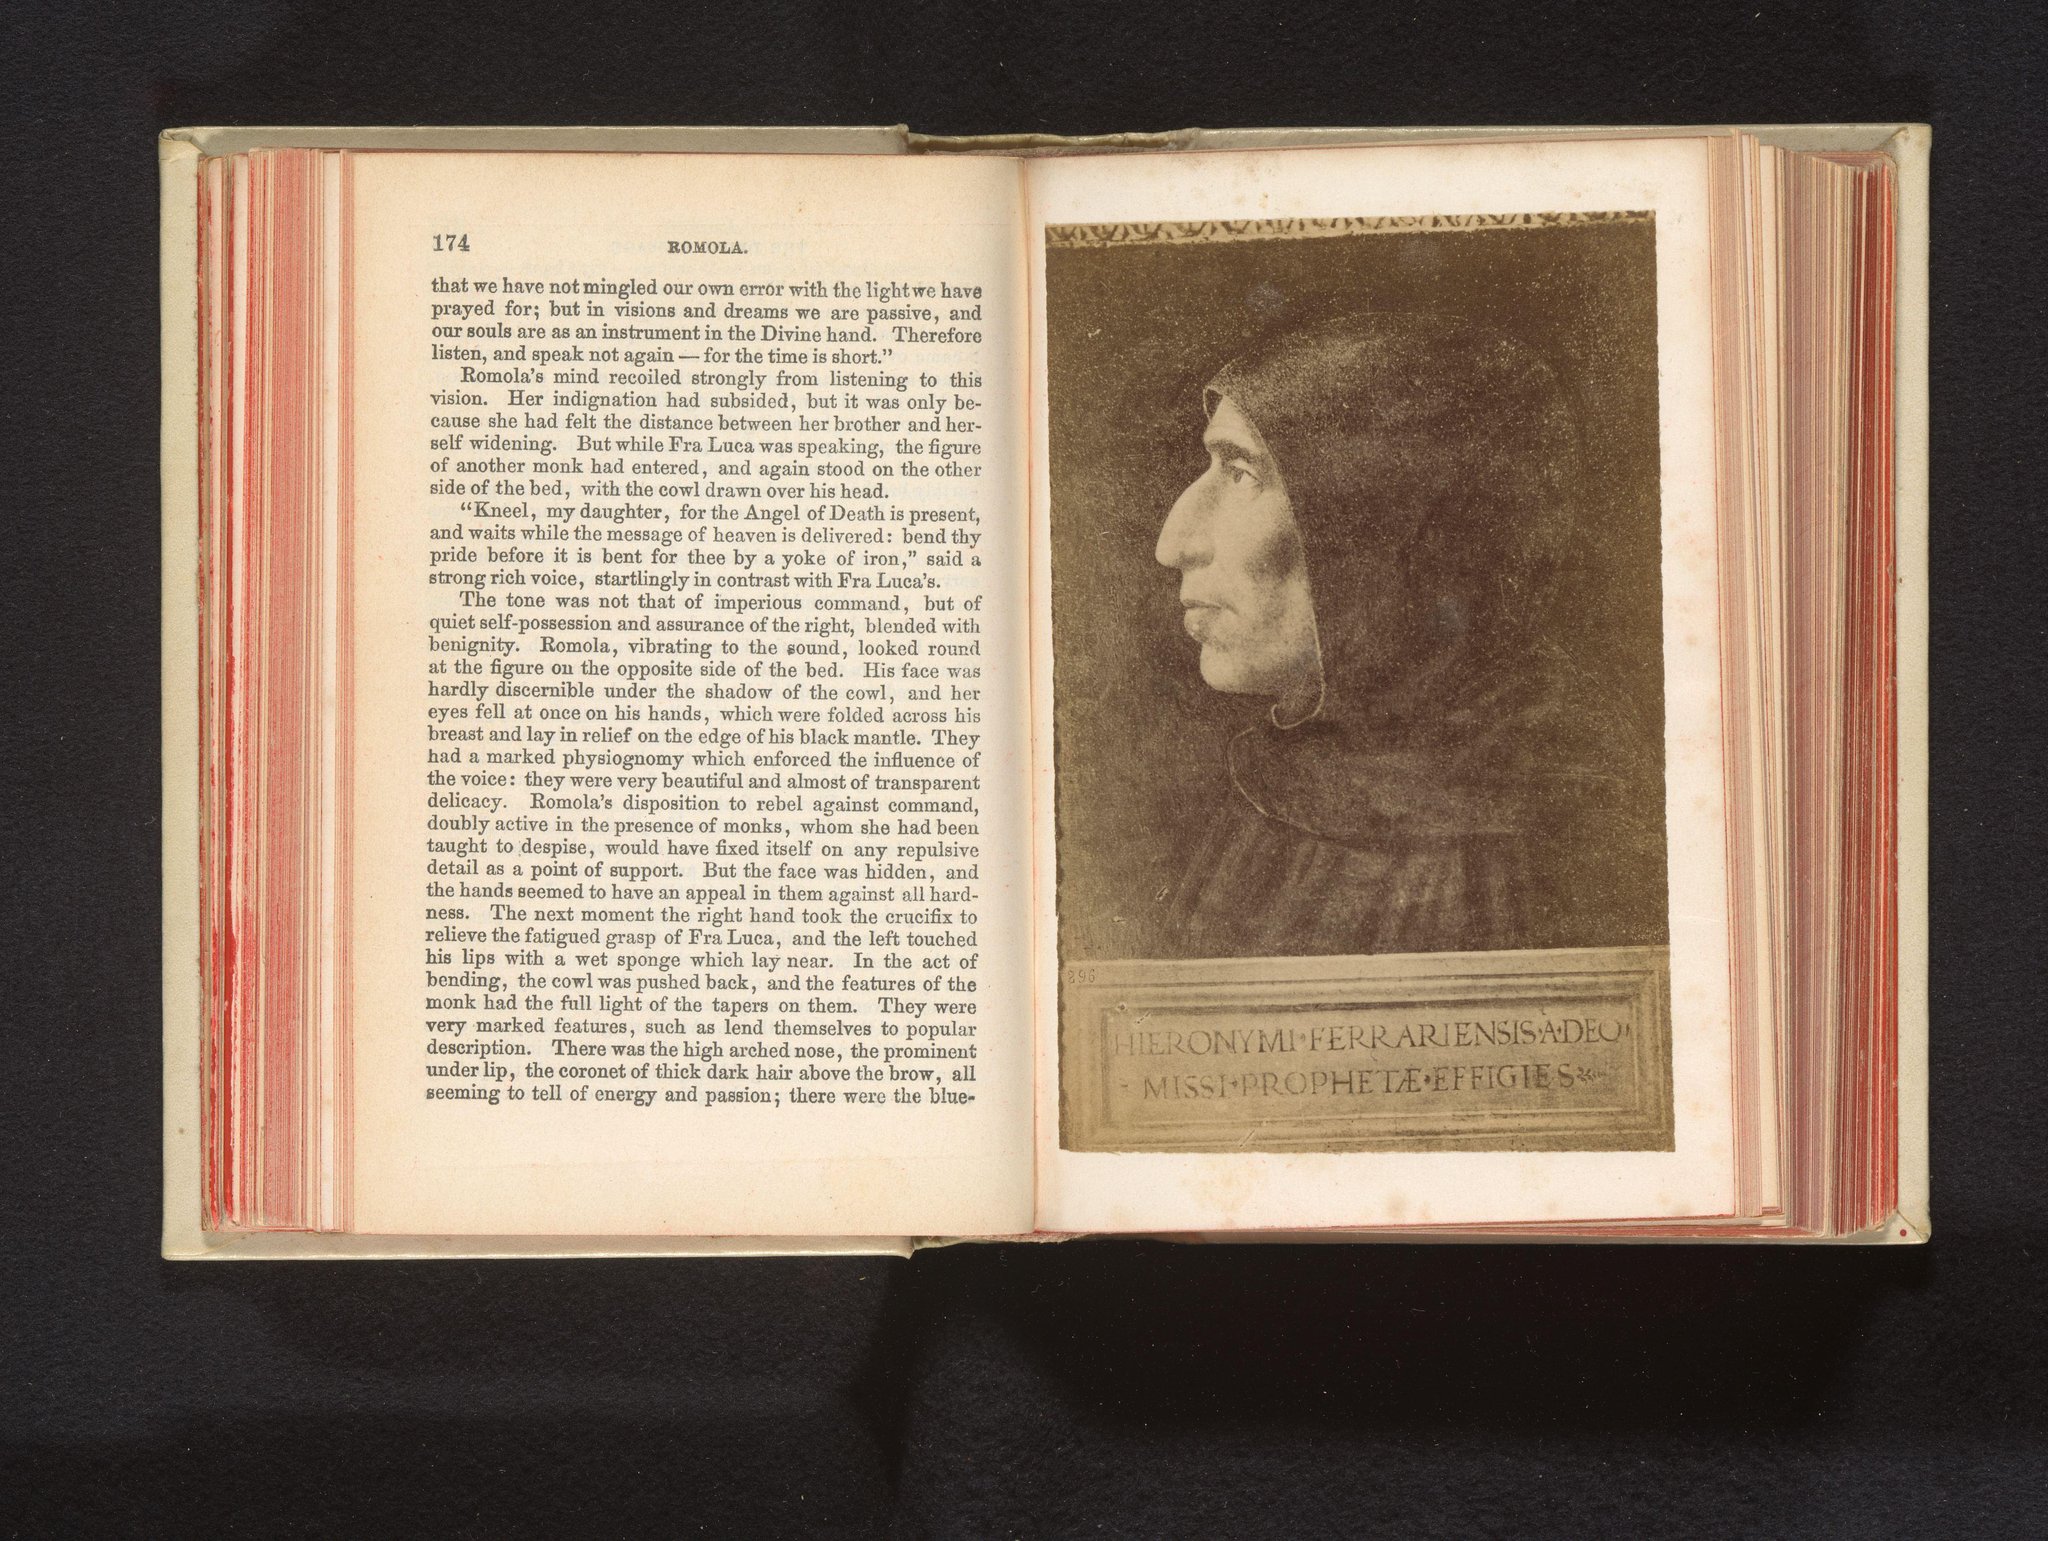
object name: page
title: Fotoreproductie van een schilderij, voorstellende een portret van Girolamo Savonarola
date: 1858-1863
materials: photographic support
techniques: albumen print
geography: florence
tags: historical persons